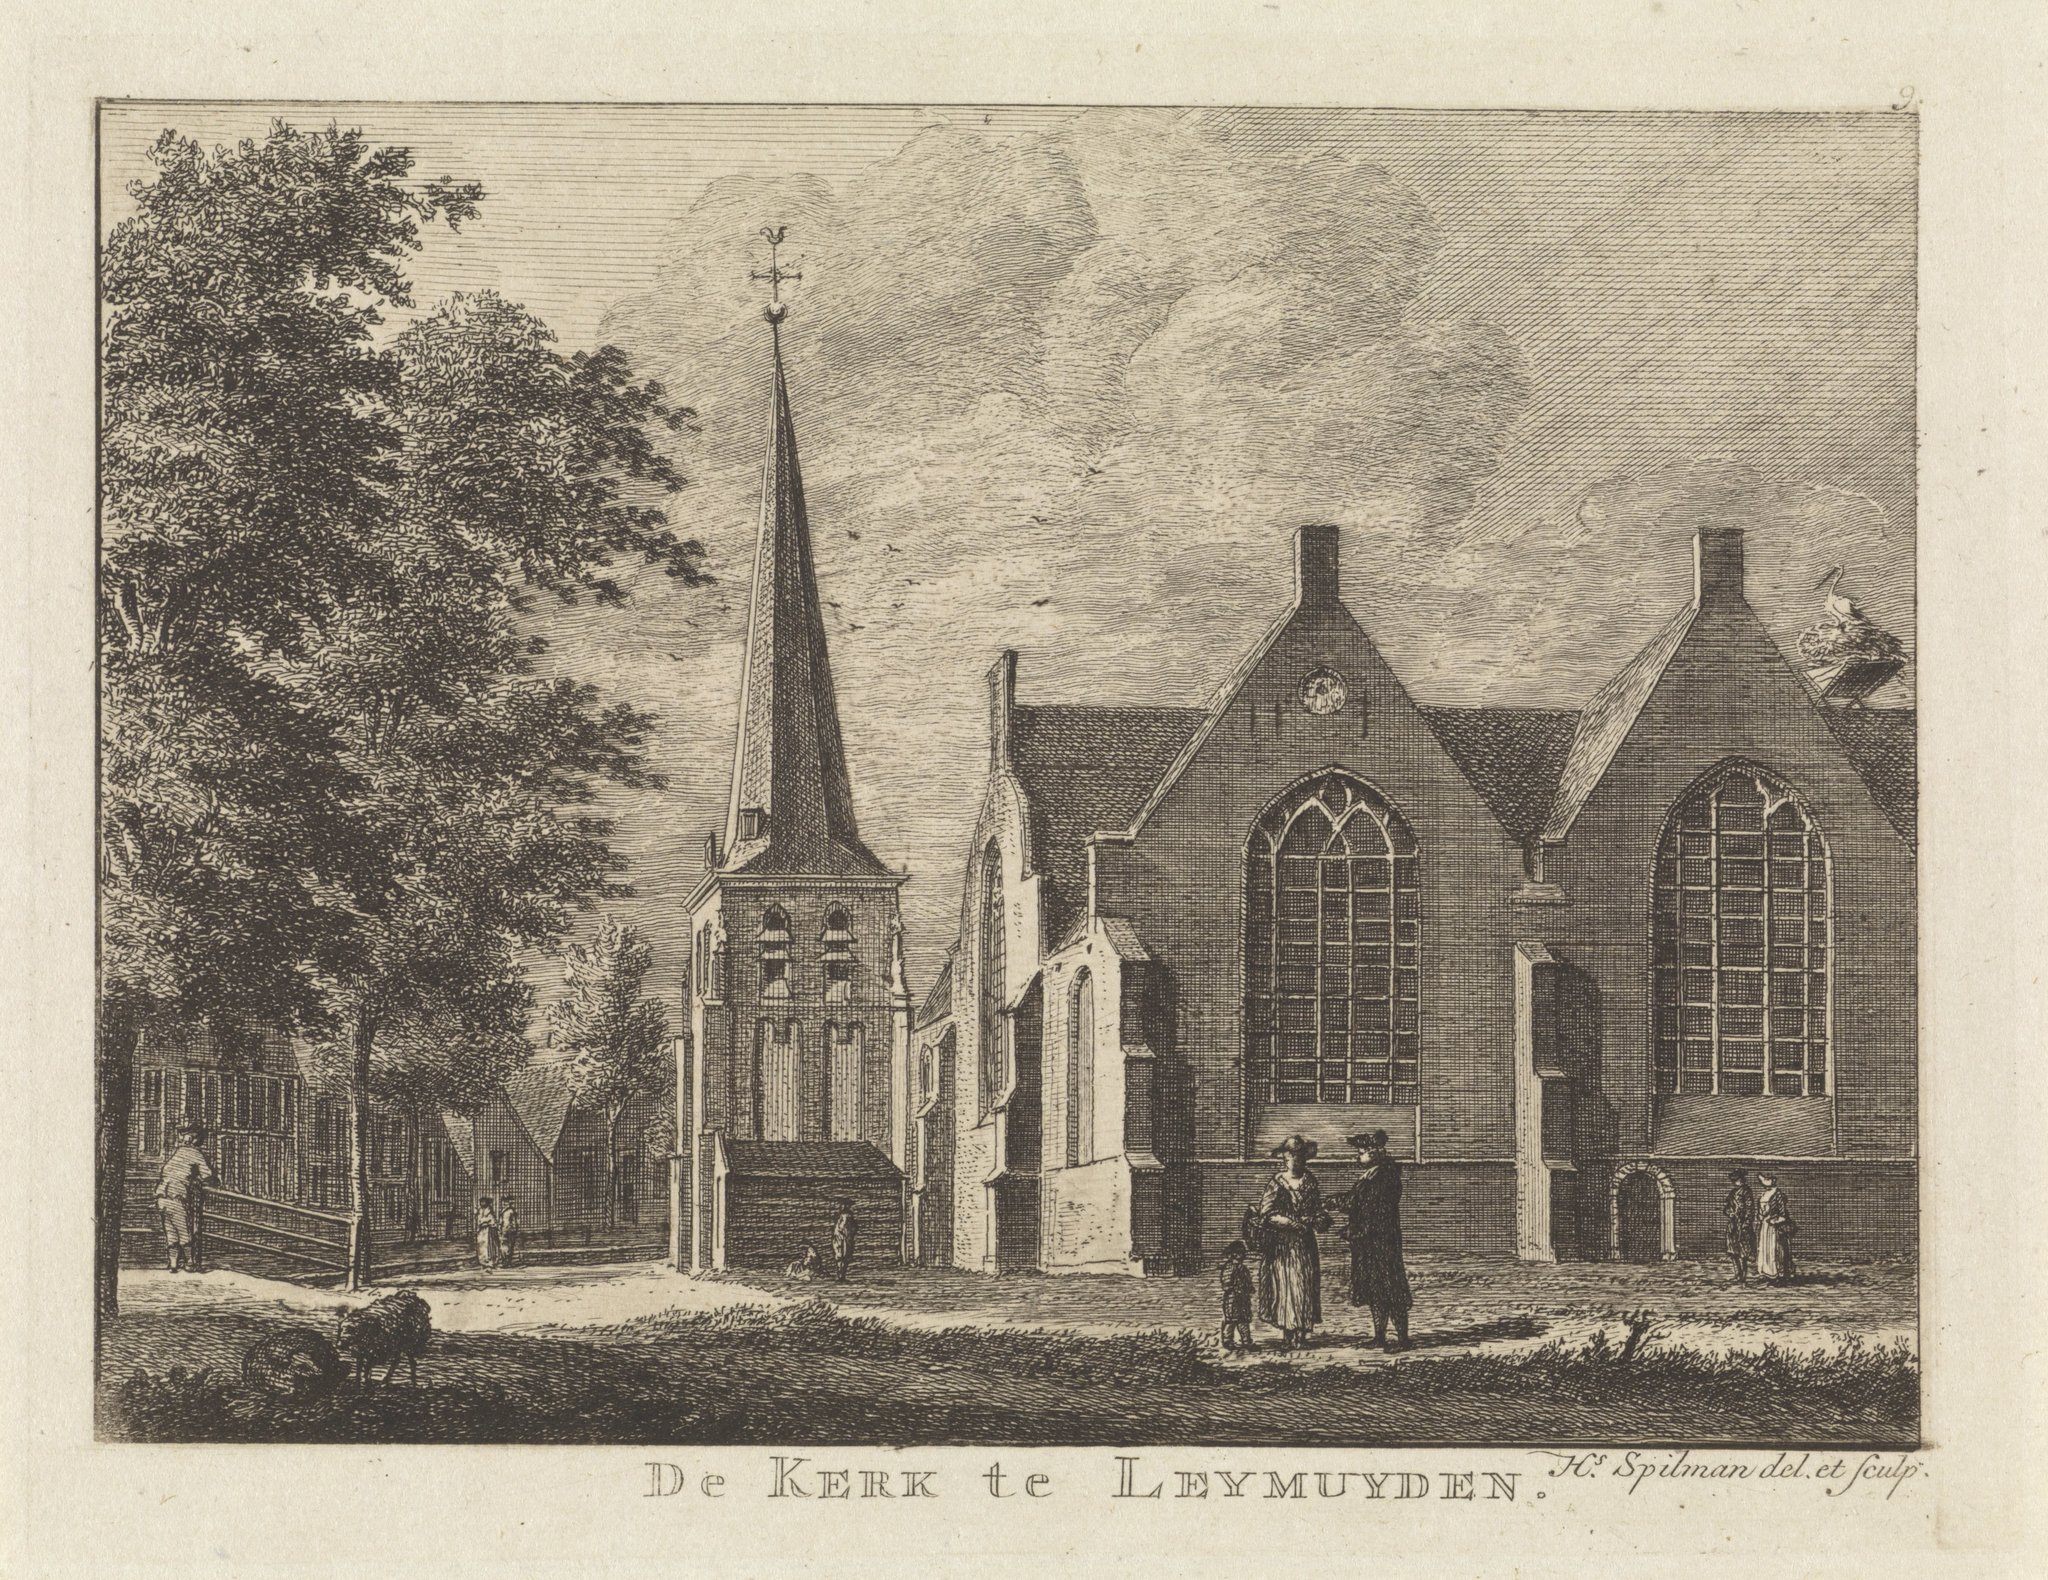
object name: print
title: Gezicht op Leimuiden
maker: hendrik spilman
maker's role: draughtsman, painter, print maker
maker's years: 1721-1784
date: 1742-1784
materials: paper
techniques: etching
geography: haarlem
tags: church (exterior), village square, place (+ city(-scape) with figures, staffage)